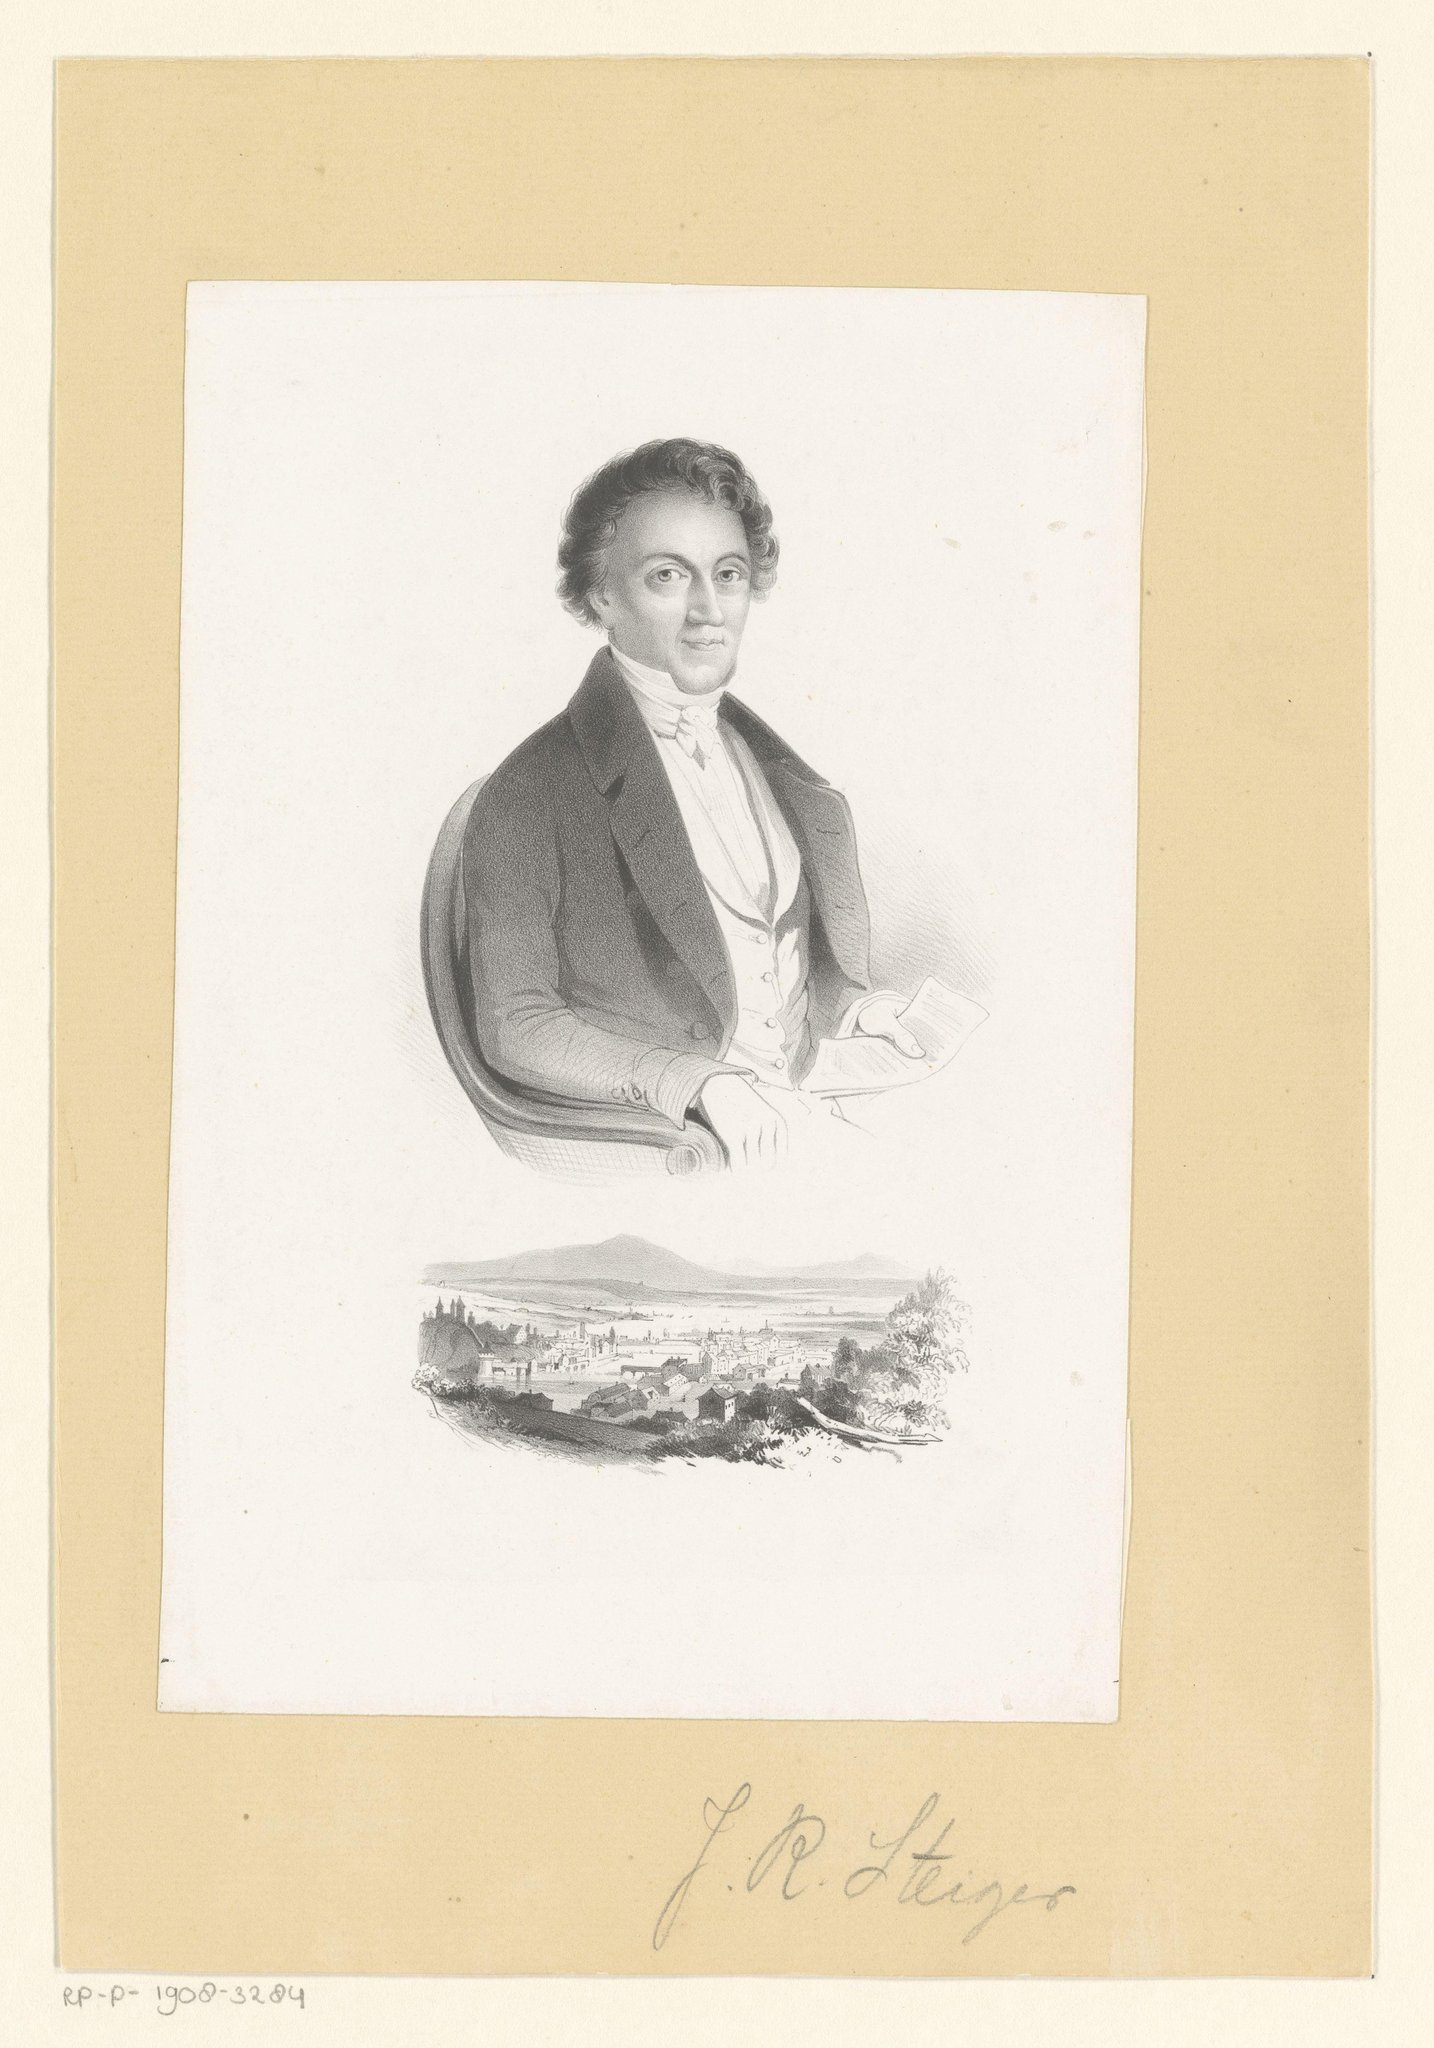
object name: print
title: Portret van Jakob Robert Steiger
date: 1822-1845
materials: paper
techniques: lithograph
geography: dordrecht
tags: sitting figure, city-view in general; 'veduta', historical persons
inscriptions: collector's mark: Lugt 2228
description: De geportretteerde zit op een stoel en heeft een beschreven stuk papier in zijn linkerhand. Onder het portret een stadsgezicht.